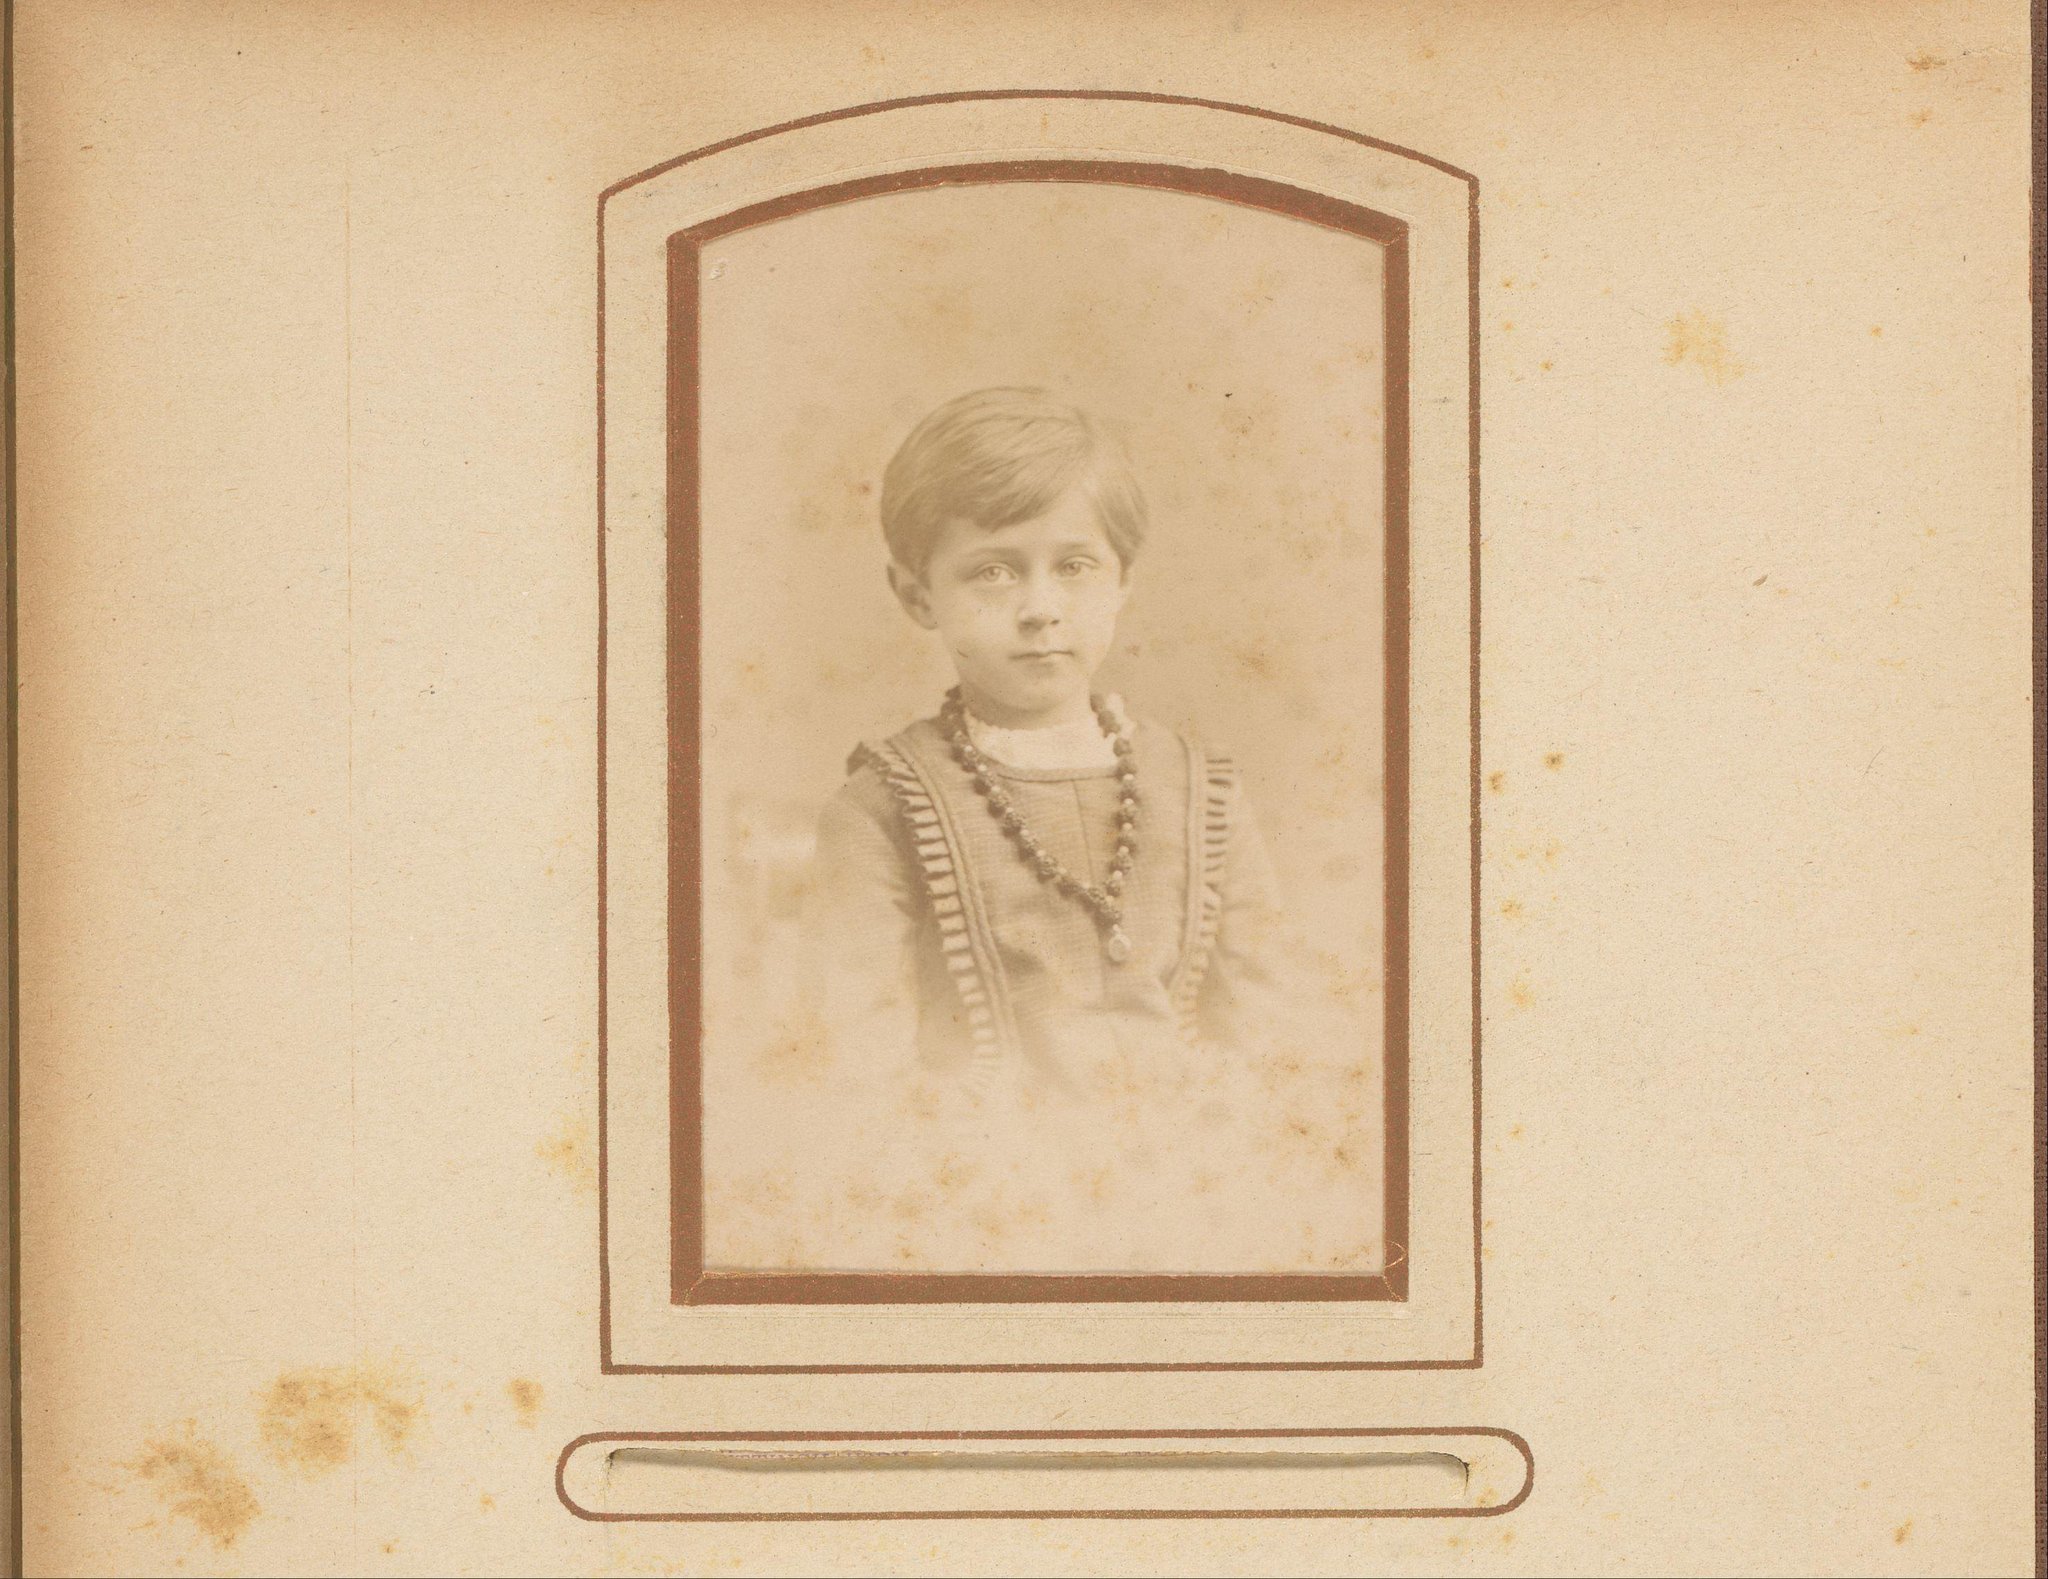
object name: album leaf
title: Portret van een jongen met ketting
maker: max büttinghausen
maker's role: fotograaf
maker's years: 1847-1906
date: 1877-1906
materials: cardboard, photographic support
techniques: albumen print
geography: netherlands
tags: boy (child between toddler and youth)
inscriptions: inscription: ‘Amsterdam 1877/ M. Büttinghausen/ Photografisch artistisch Atelier/ Singel b/d Torensteeg G.133/ Amsterdam/ Catharijne Singel L.39.G/ Utrecht’